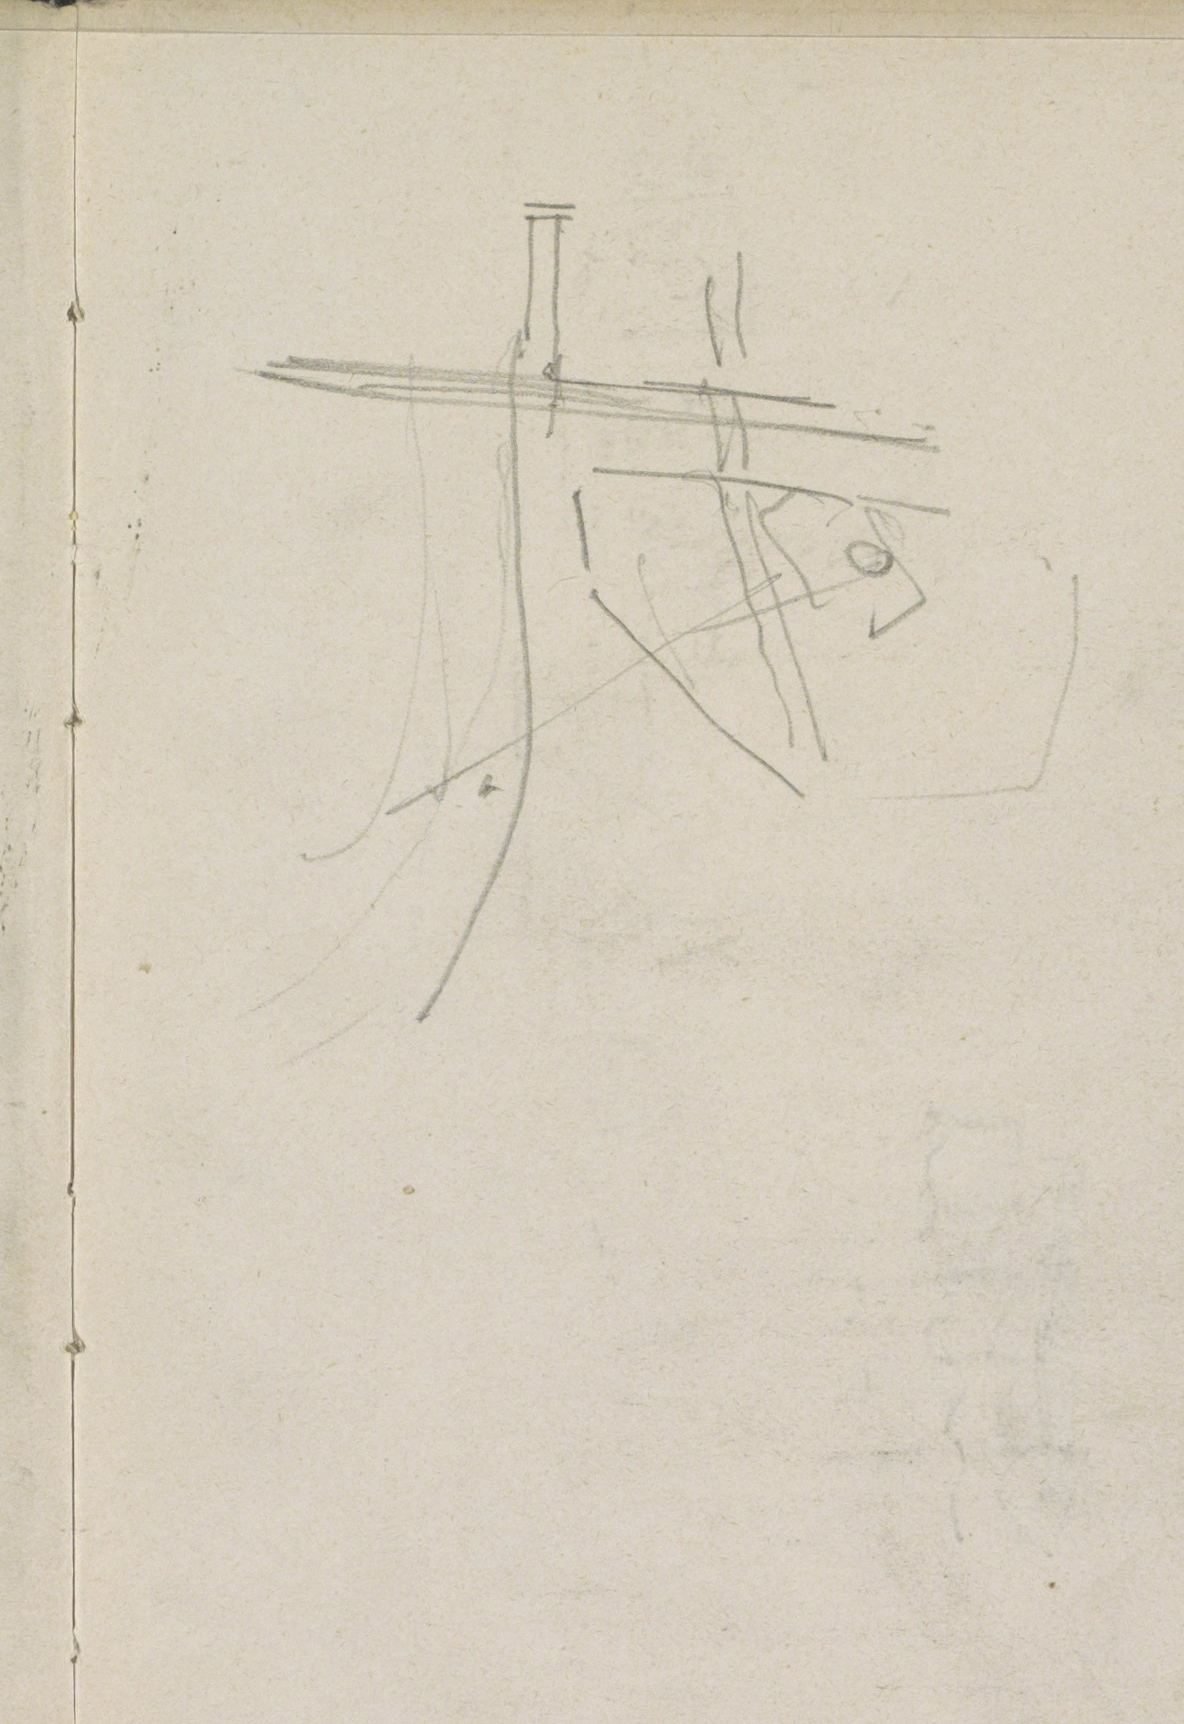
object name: sketchbook leaf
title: Studie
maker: george hendrik breitner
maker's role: draughtsman, painter, print maker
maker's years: 1857-1923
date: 1886-1903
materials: paper, pencil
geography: amsterdam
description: Pagina 4 uit een schetsboek met 46 bladen.